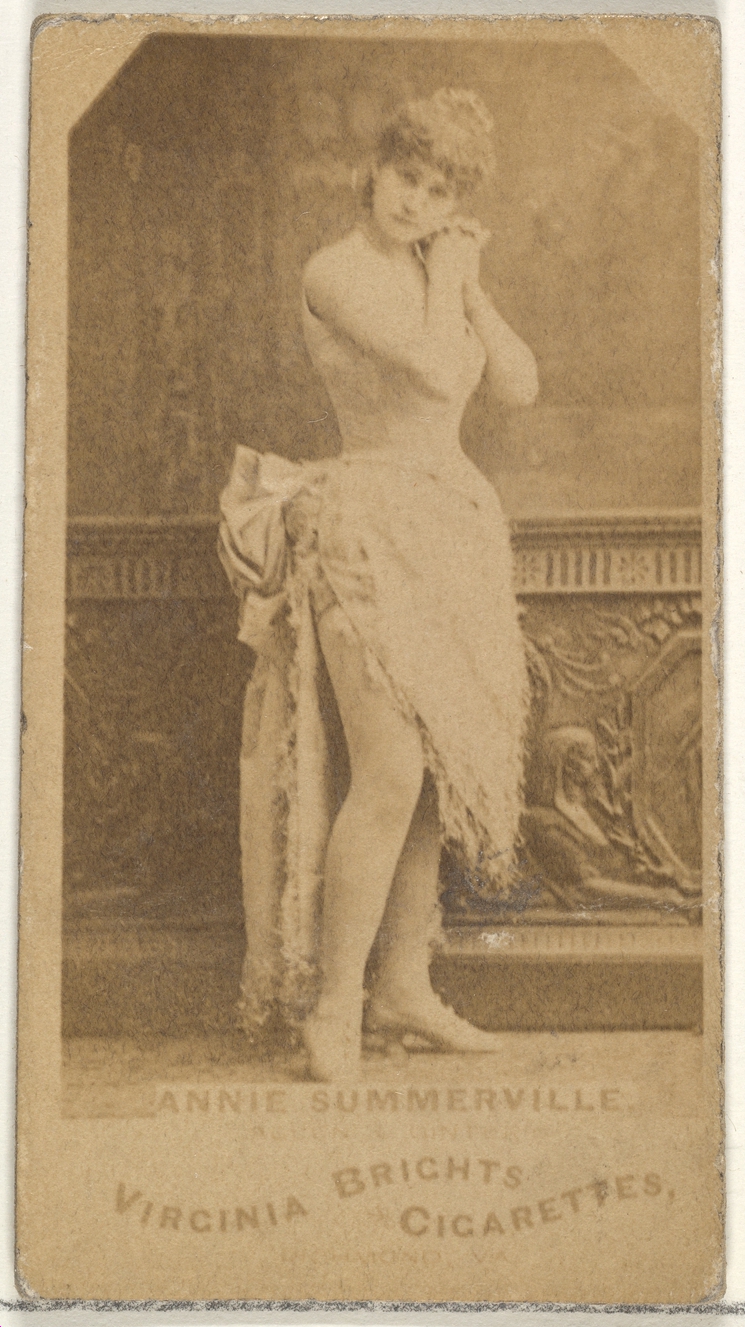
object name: photograph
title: Annie Summerville, from the Actors and Actresses series (N45, Type 1) for Virginia Brights Cigarettes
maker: allen & ginter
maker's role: publisher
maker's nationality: american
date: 1888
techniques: albumen silver print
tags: portraits,women,actresses